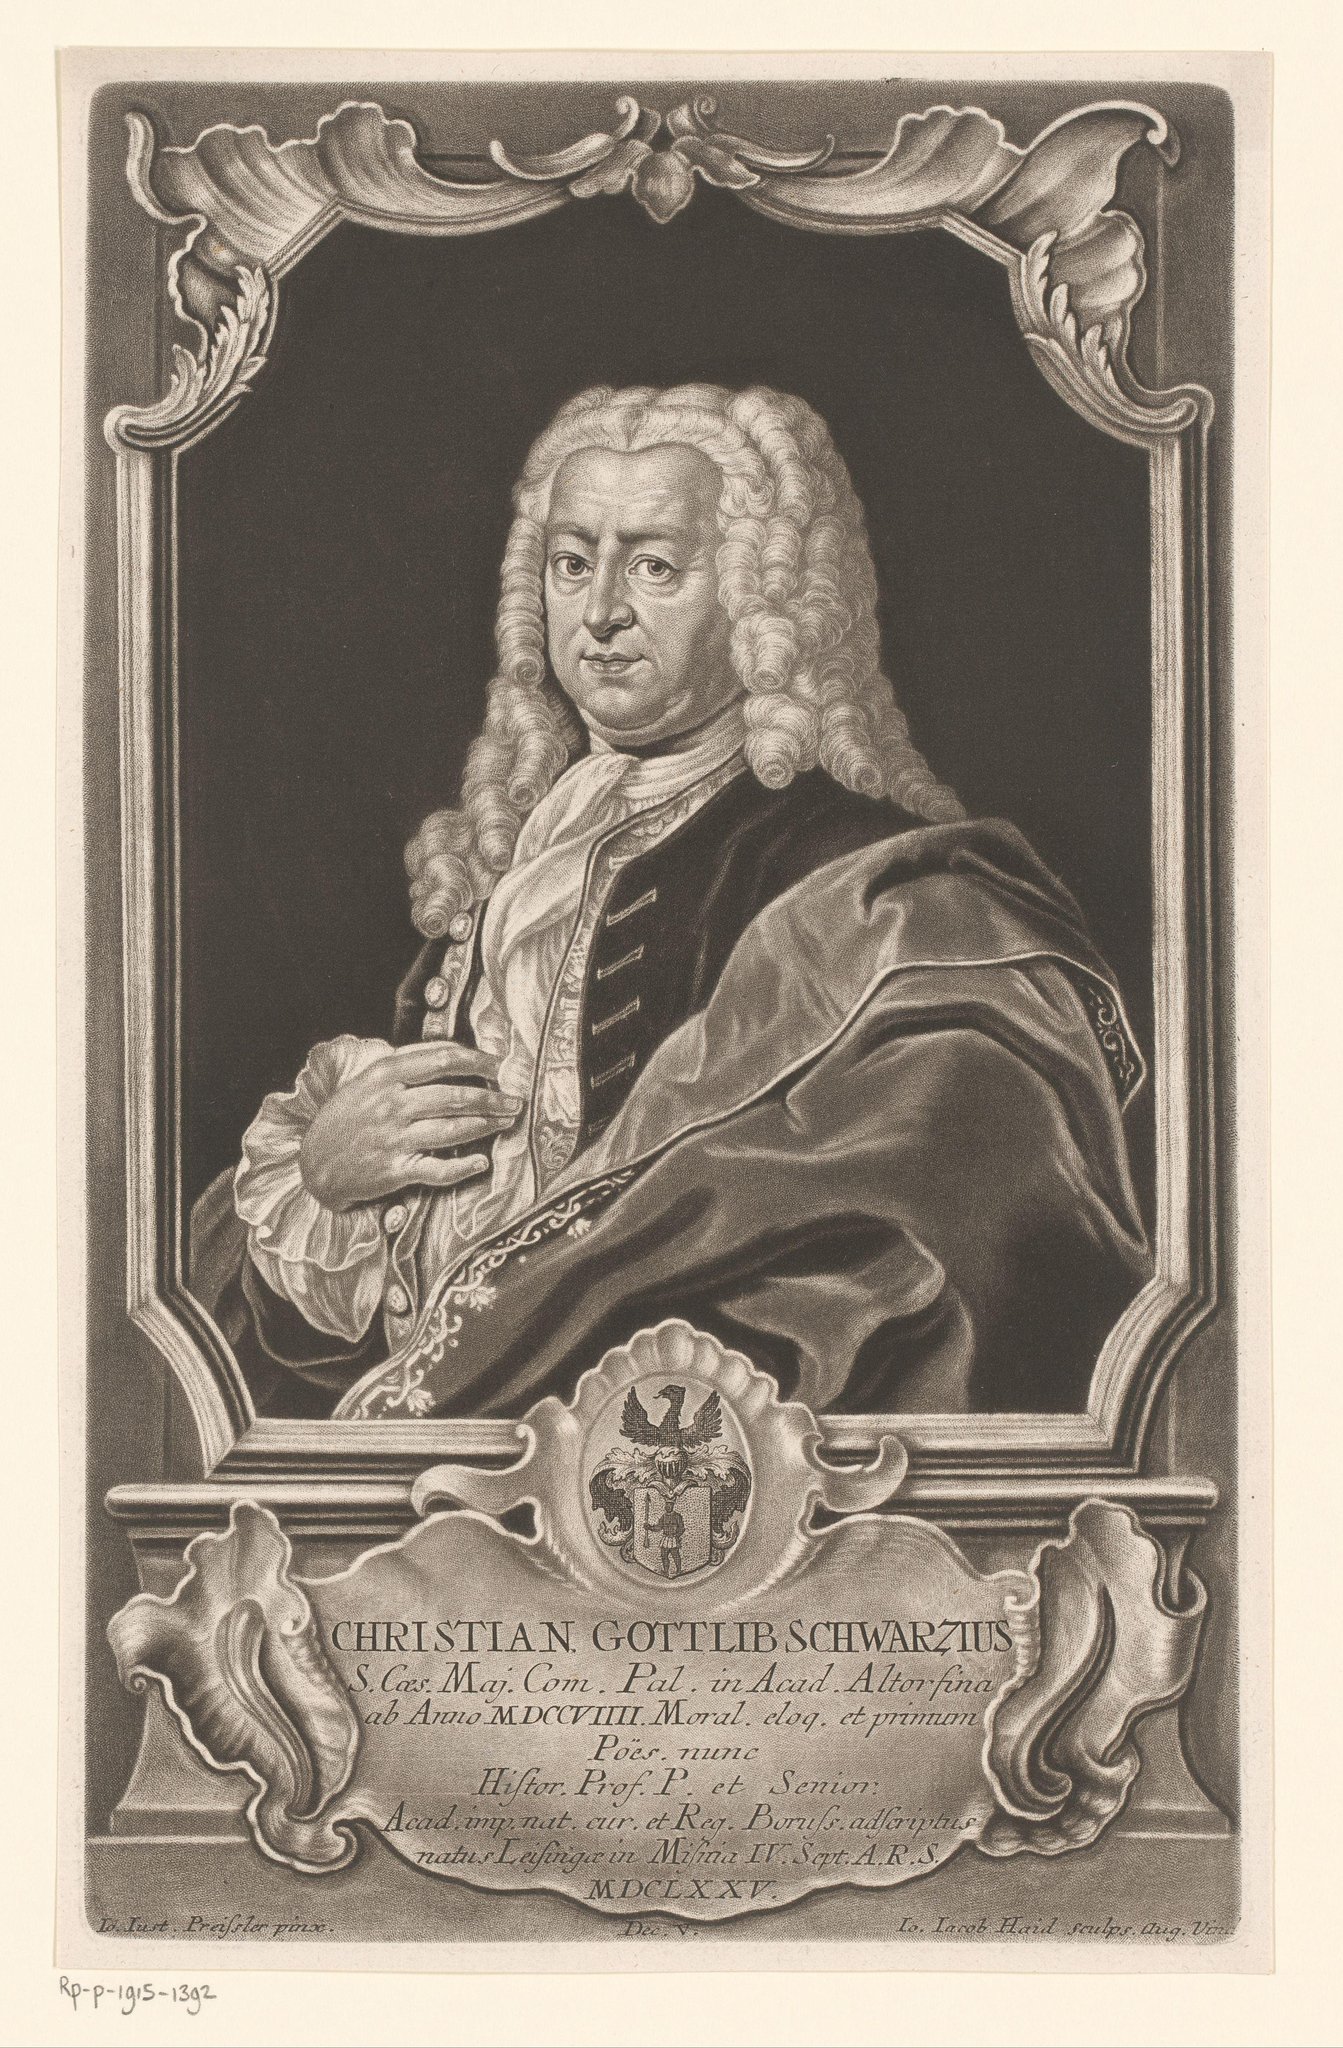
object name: print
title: Portret van Christian Gottlieb Schwarz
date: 1746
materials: paper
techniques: etching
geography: augsburg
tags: rocaille ornament, historical persons, armorial bearing, heraldry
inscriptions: collector's mark: Lugt 2228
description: Prent gebruikt voor: Brucker, Jacob. Bildersal heutiges Tages lebender und durch Gelahrheit berühmter Schrifftsteller. Augsburg: Johann Jacob Haid, 1746.